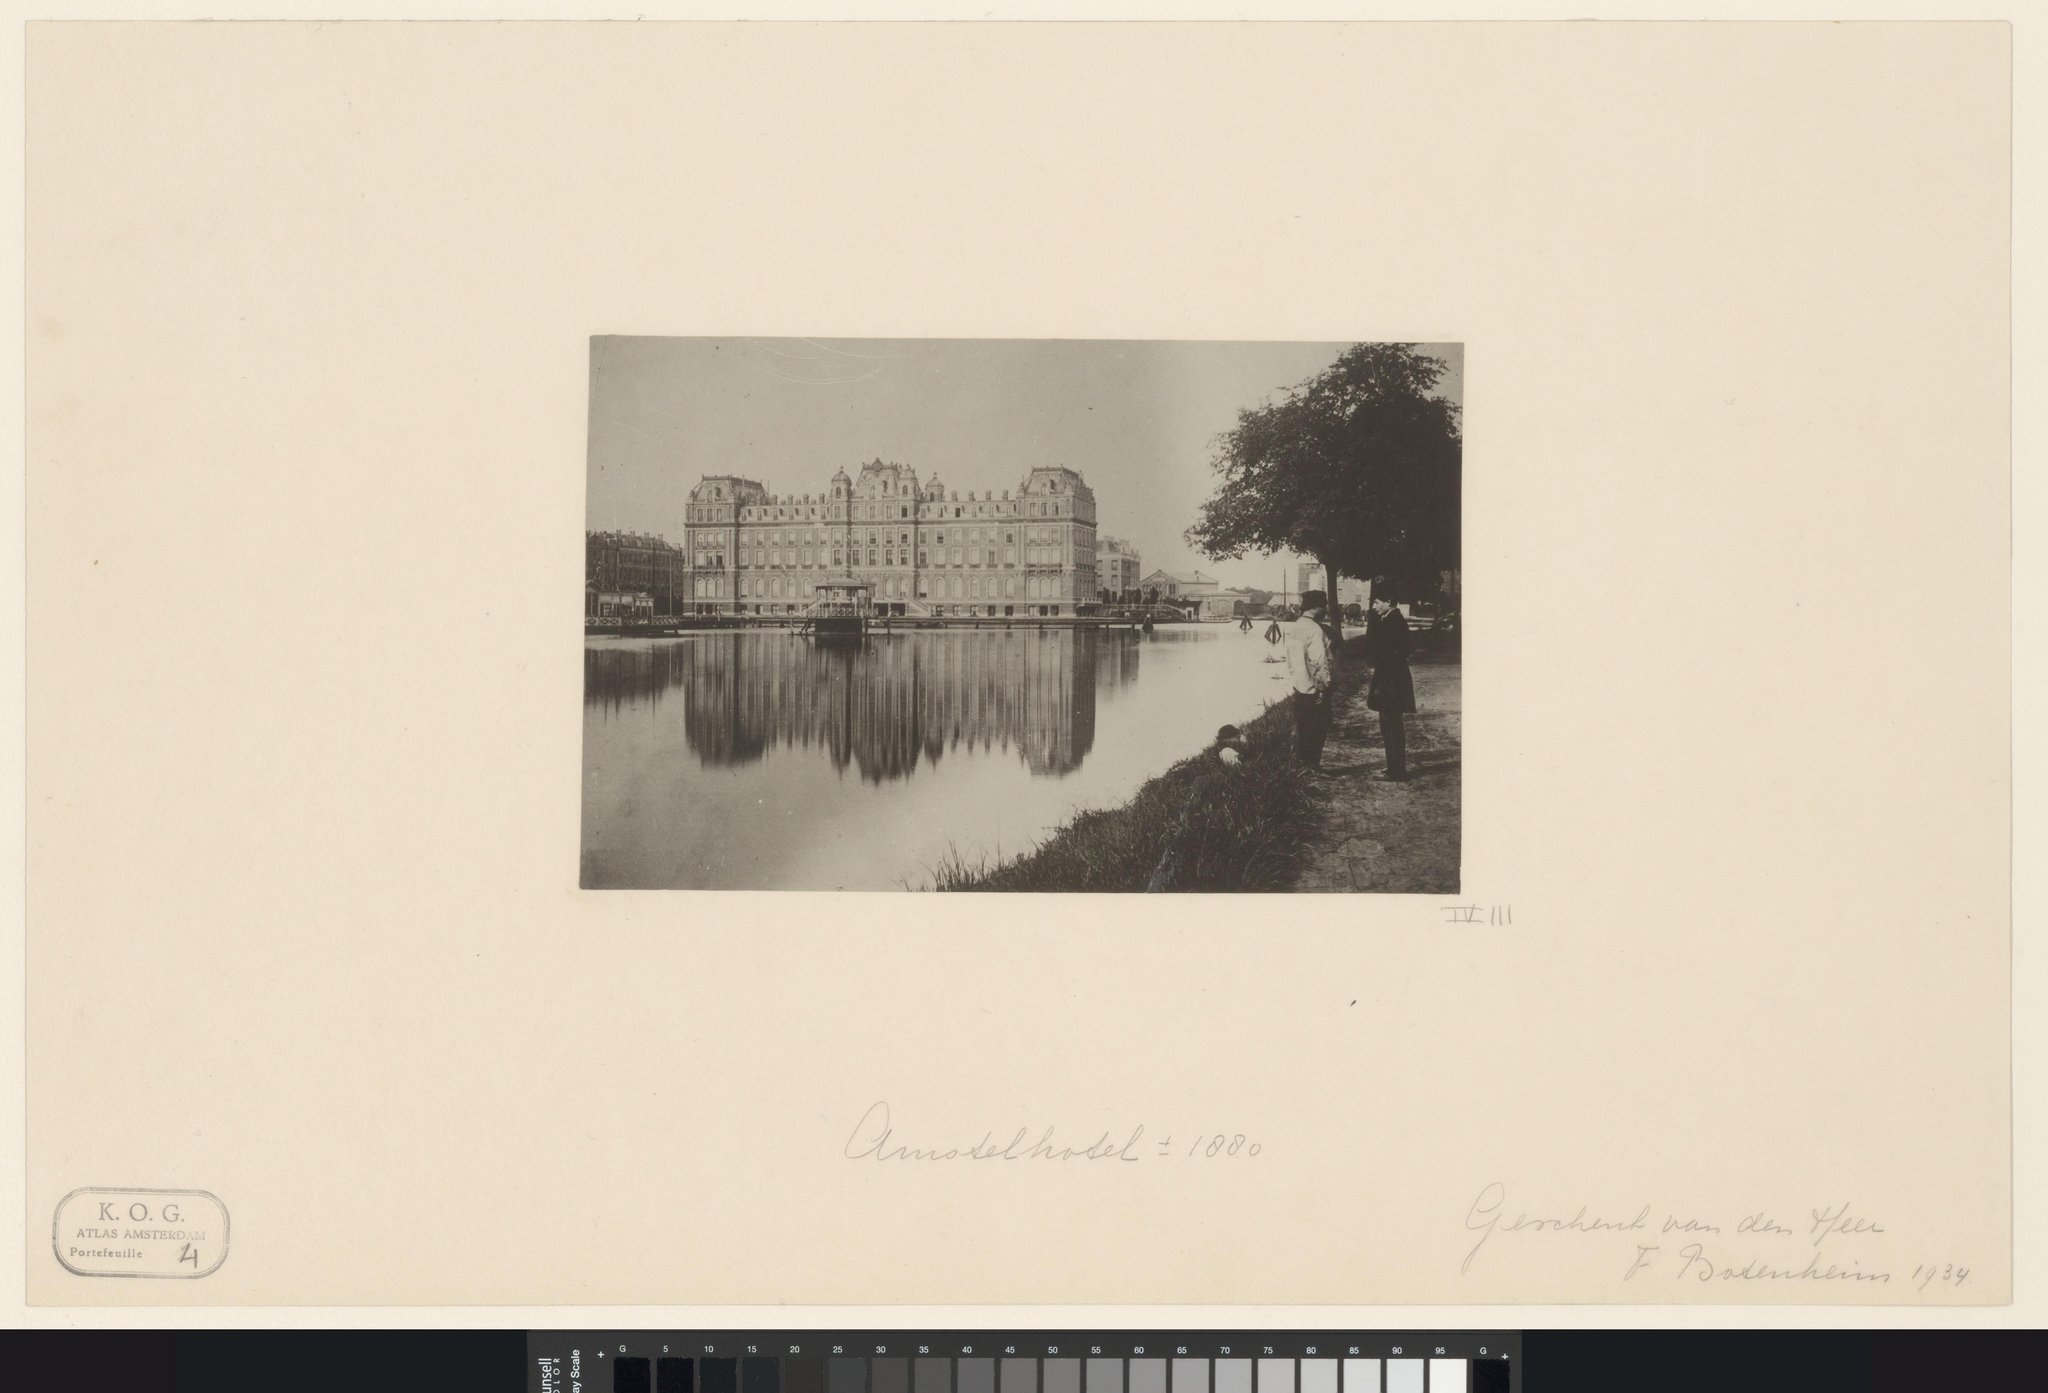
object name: photograph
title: Gezicht op de Binnen-Amstel en het Amstel Hotel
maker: Anonymous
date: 1880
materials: paper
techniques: gelatin silver print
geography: amsterdam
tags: city-view in general; 'veduta', river, hôtel, i.e. small palace in city, bridge in city across river, canal, etc.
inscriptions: collector's mark: ‘4’ Lugt 1641b, inscription: ‘Amstelhotel +- 1880 / Geschenk van den Heer / F Batenheim 1934’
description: Onderwerpsrubriek binnen de Atlas Amsterdam: Amstel van Hogesluis stroomopwaarts.